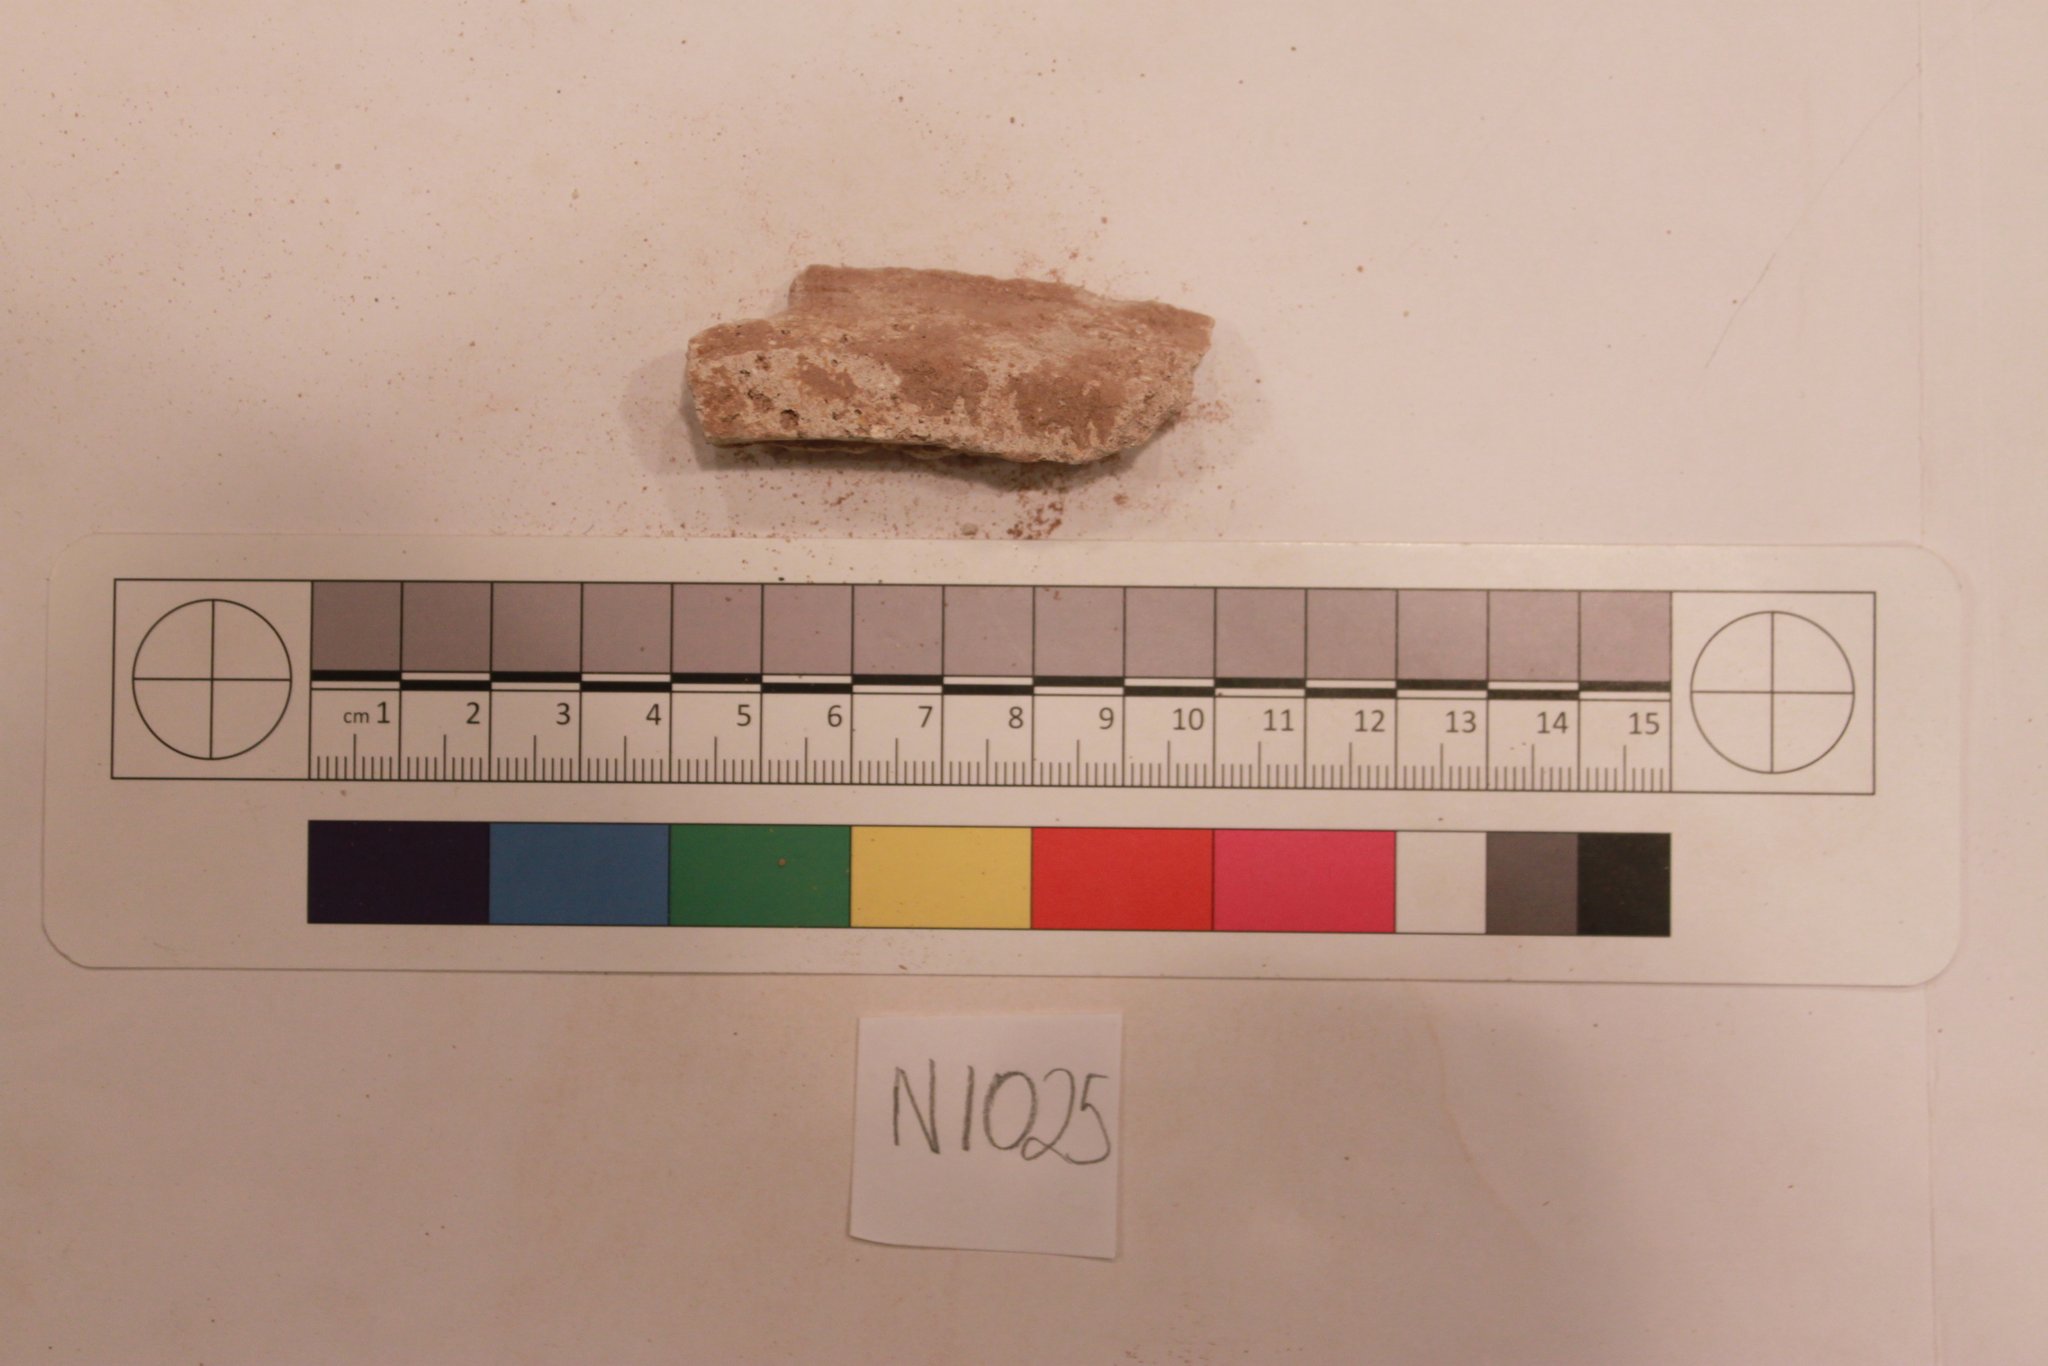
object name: fragment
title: Stucco Fragment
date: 701-1200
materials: plaster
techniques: carving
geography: iran